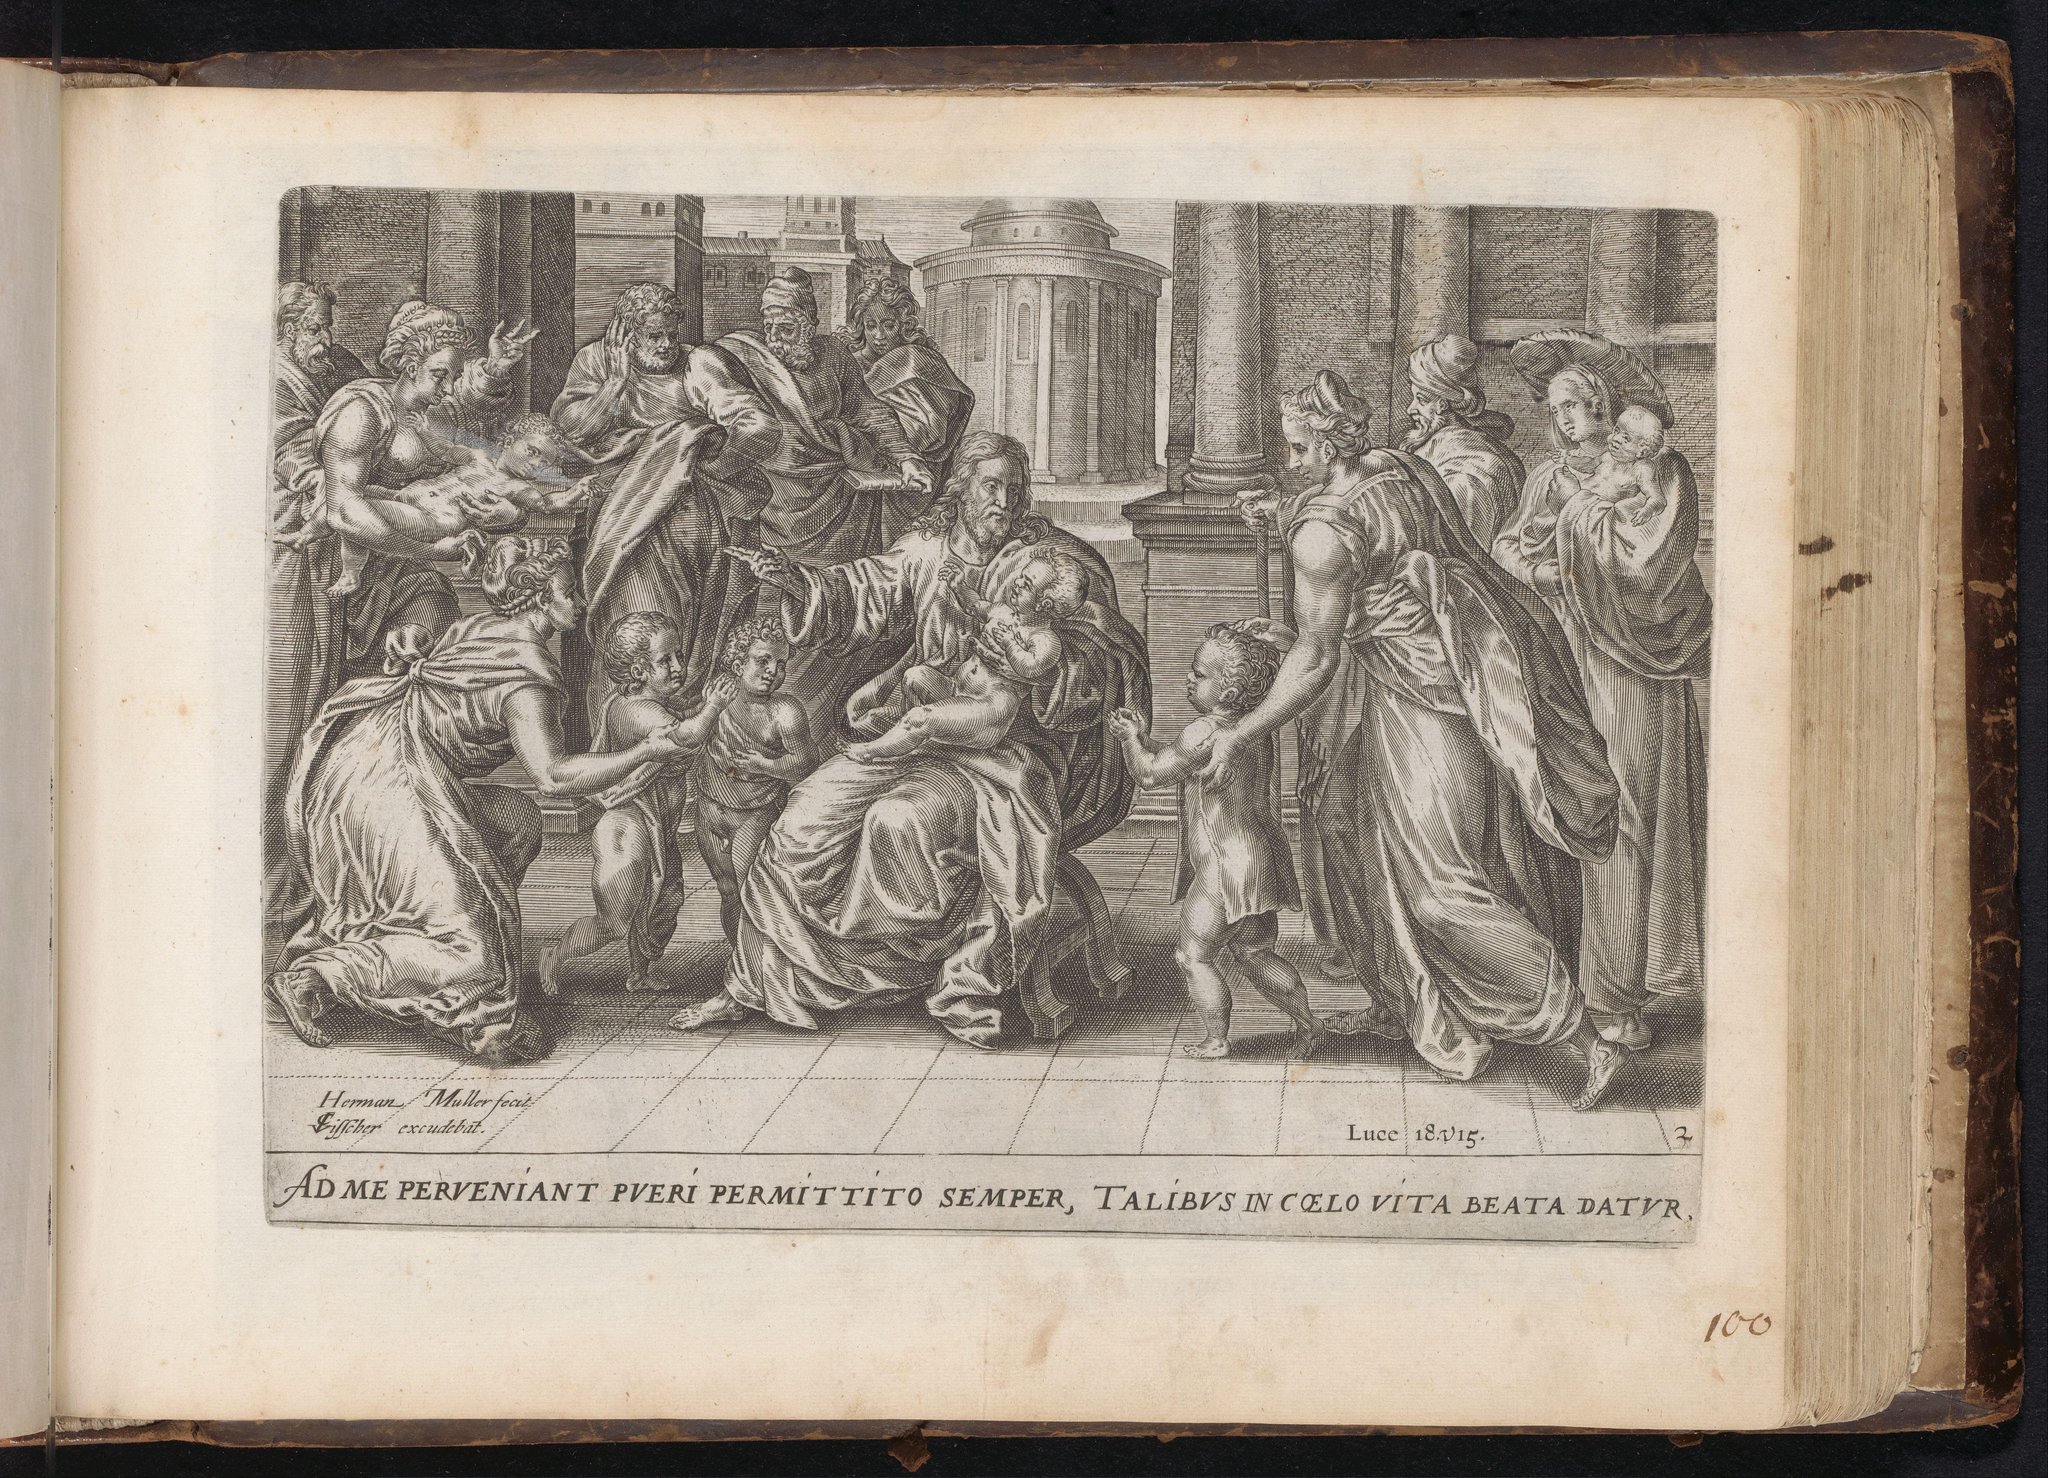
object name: print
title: De laetste Wercken Iesu in sijn omreysingh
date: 1585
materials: paper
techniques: engraving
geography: amsterdam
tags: christ blessing children brought by their mothers, usually with some disciples disapprovingly looking on (matthew 19:13-15; mark 10:13-16; luke 18:15-17)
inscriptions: serial number: ‘2’, number: ‘100’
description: Christus zegent de kinderen, die door moeders bij hem worden gebracht. De discipelen kijken toe. Onder de voorstelling een verwijzing in het Latijn naar de Bijbeltekst in Luc. 18:15. Deze prent maakt deel uit van een album.